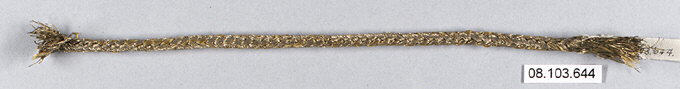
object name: cord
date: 1701-1900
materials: metal thread